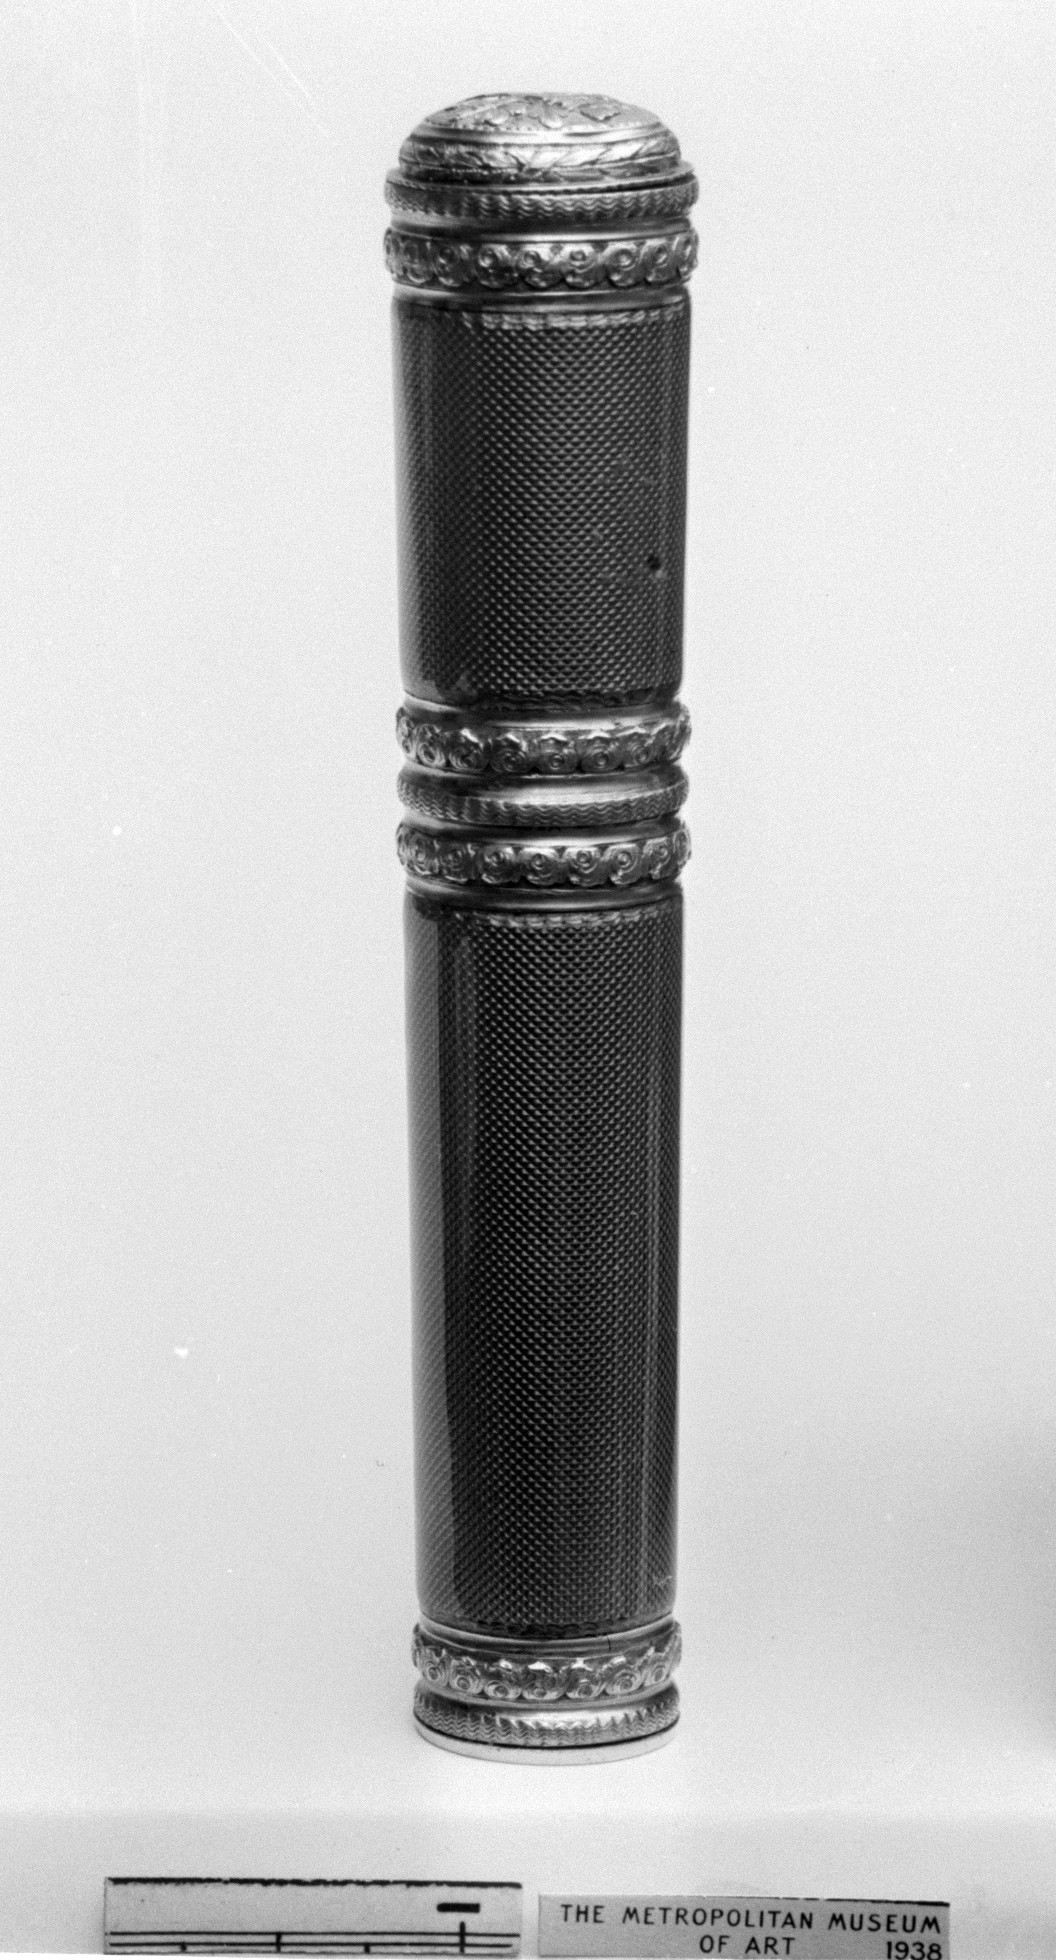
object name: étui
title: Sealing wax case (étui)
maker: nicolas-jean-baptiste choconain-delauney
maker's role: maker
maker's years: 1775-1793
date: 1777-1778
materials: enamel, gold